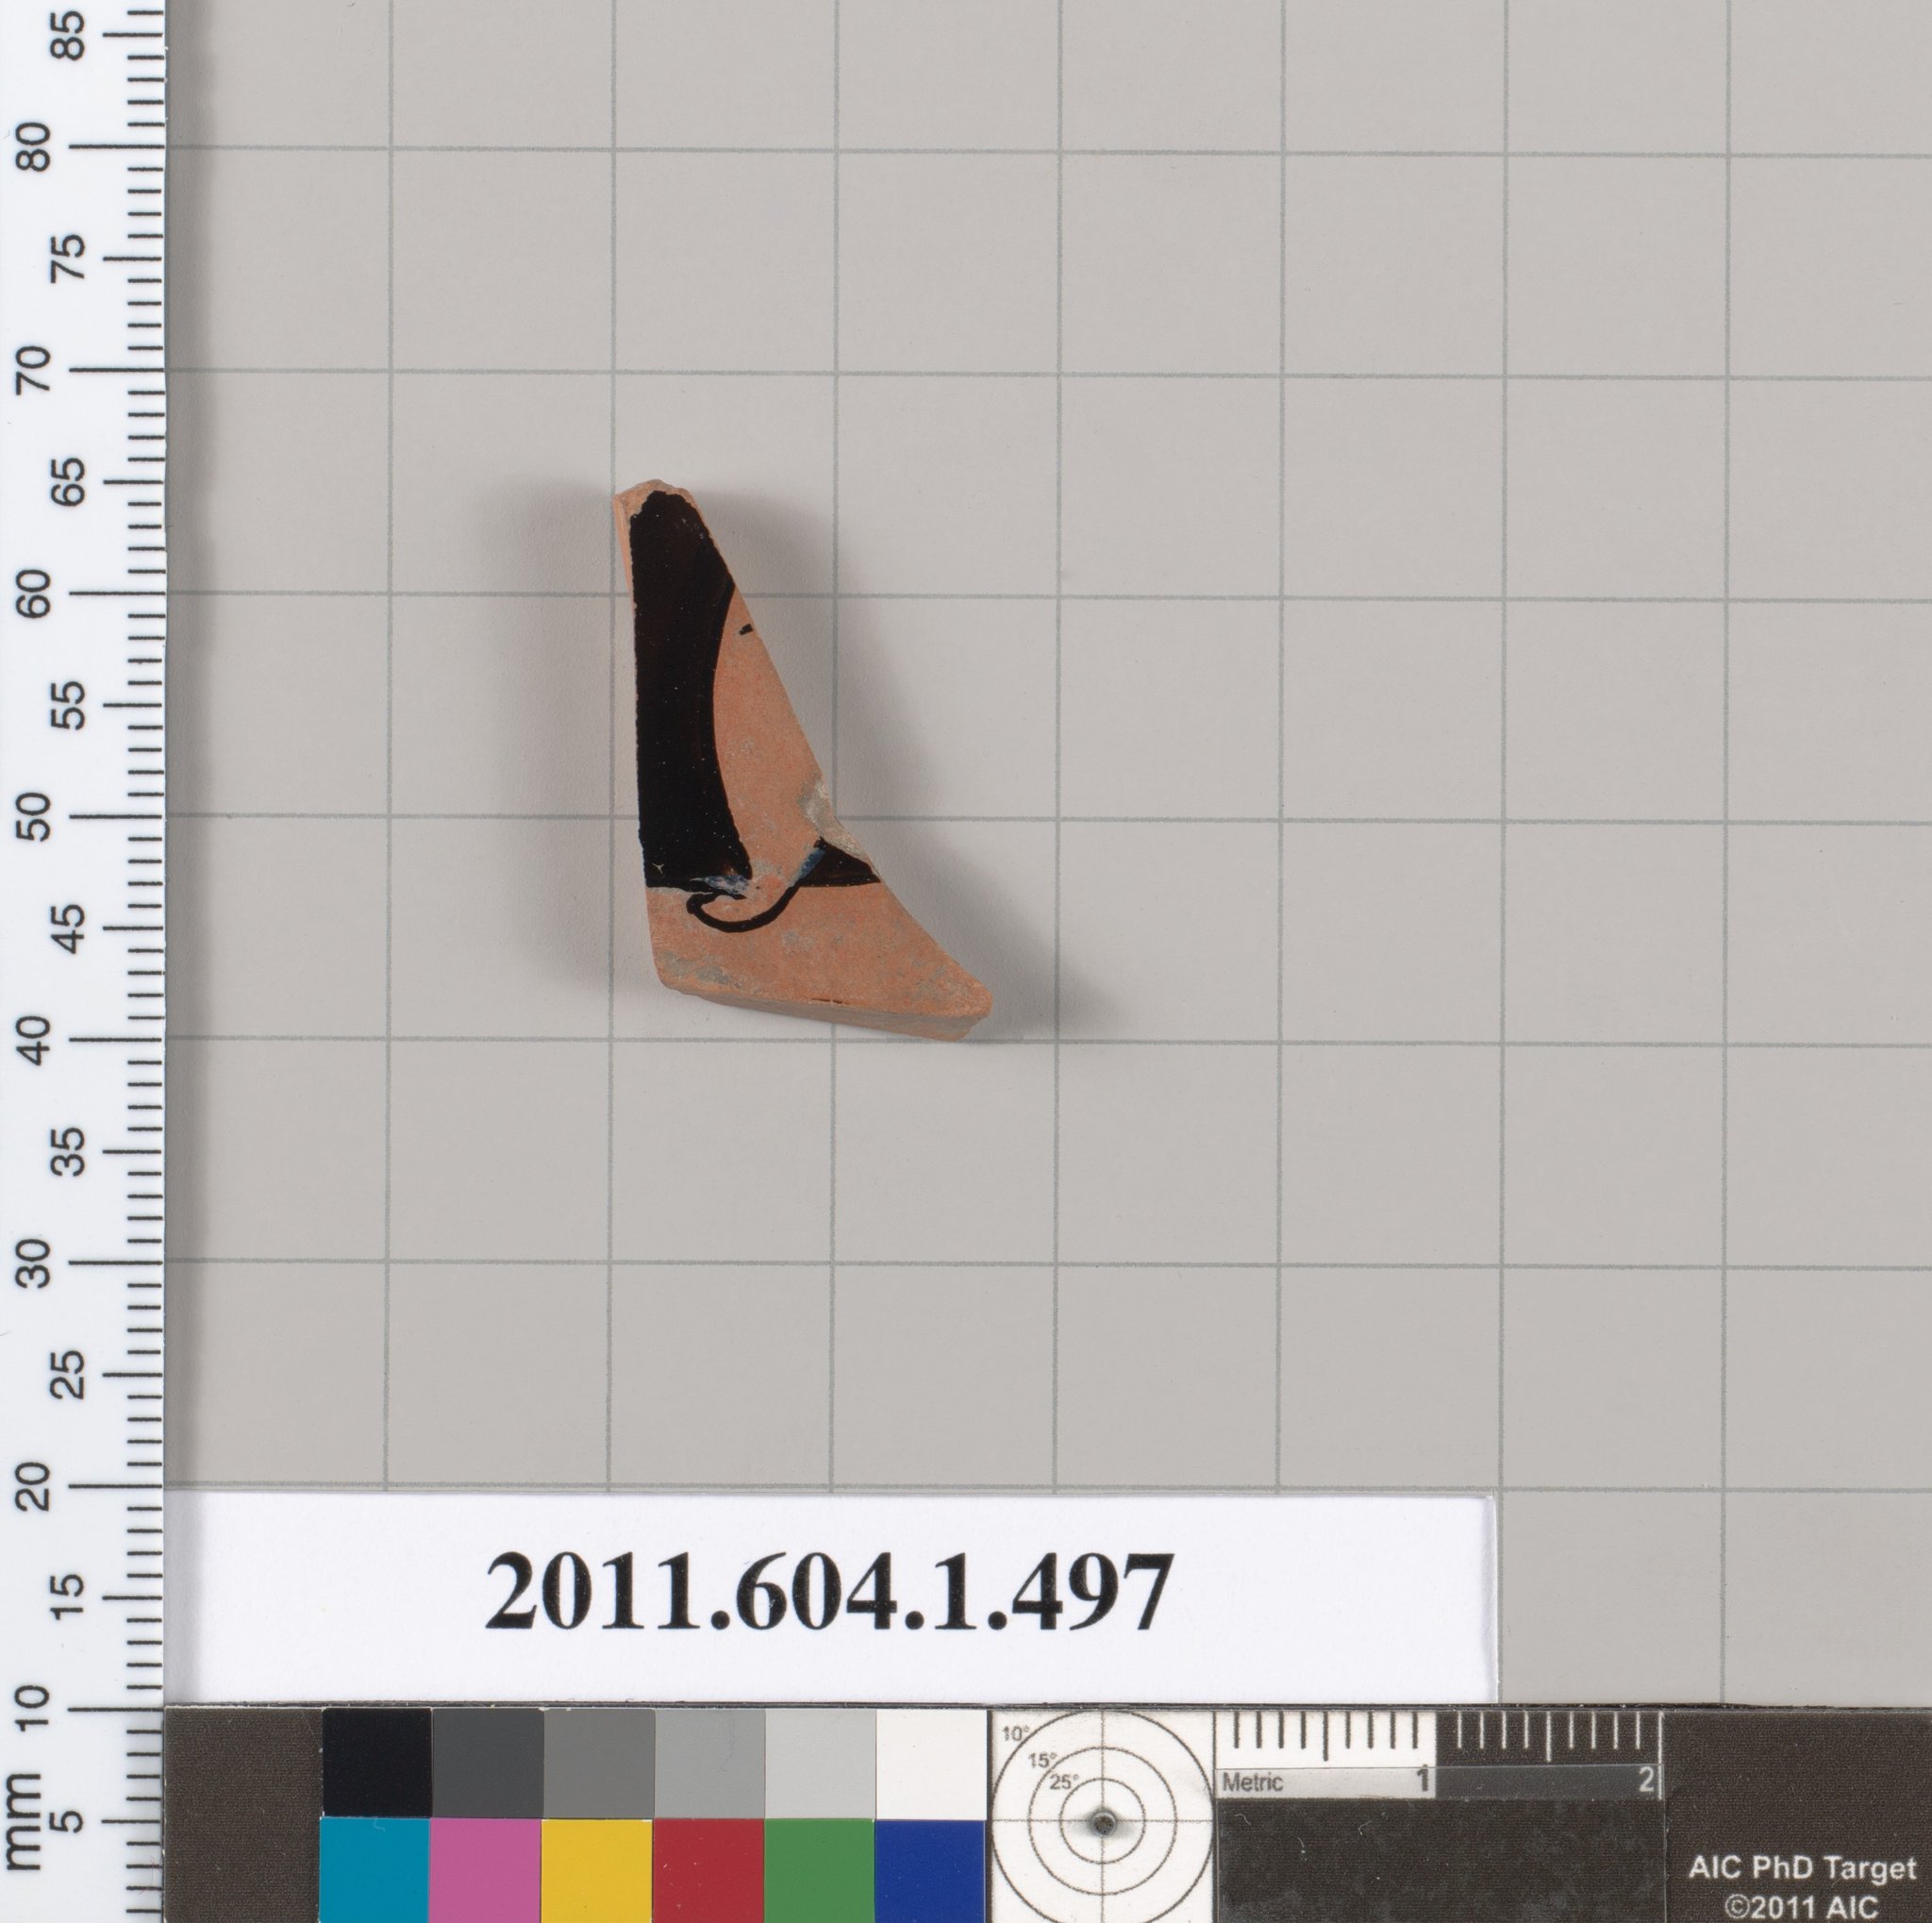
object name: kylix fragment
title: Terracotta fragment of a kylix (drinking cup)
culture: greek, attic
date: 490-480 BCE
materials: terracotta